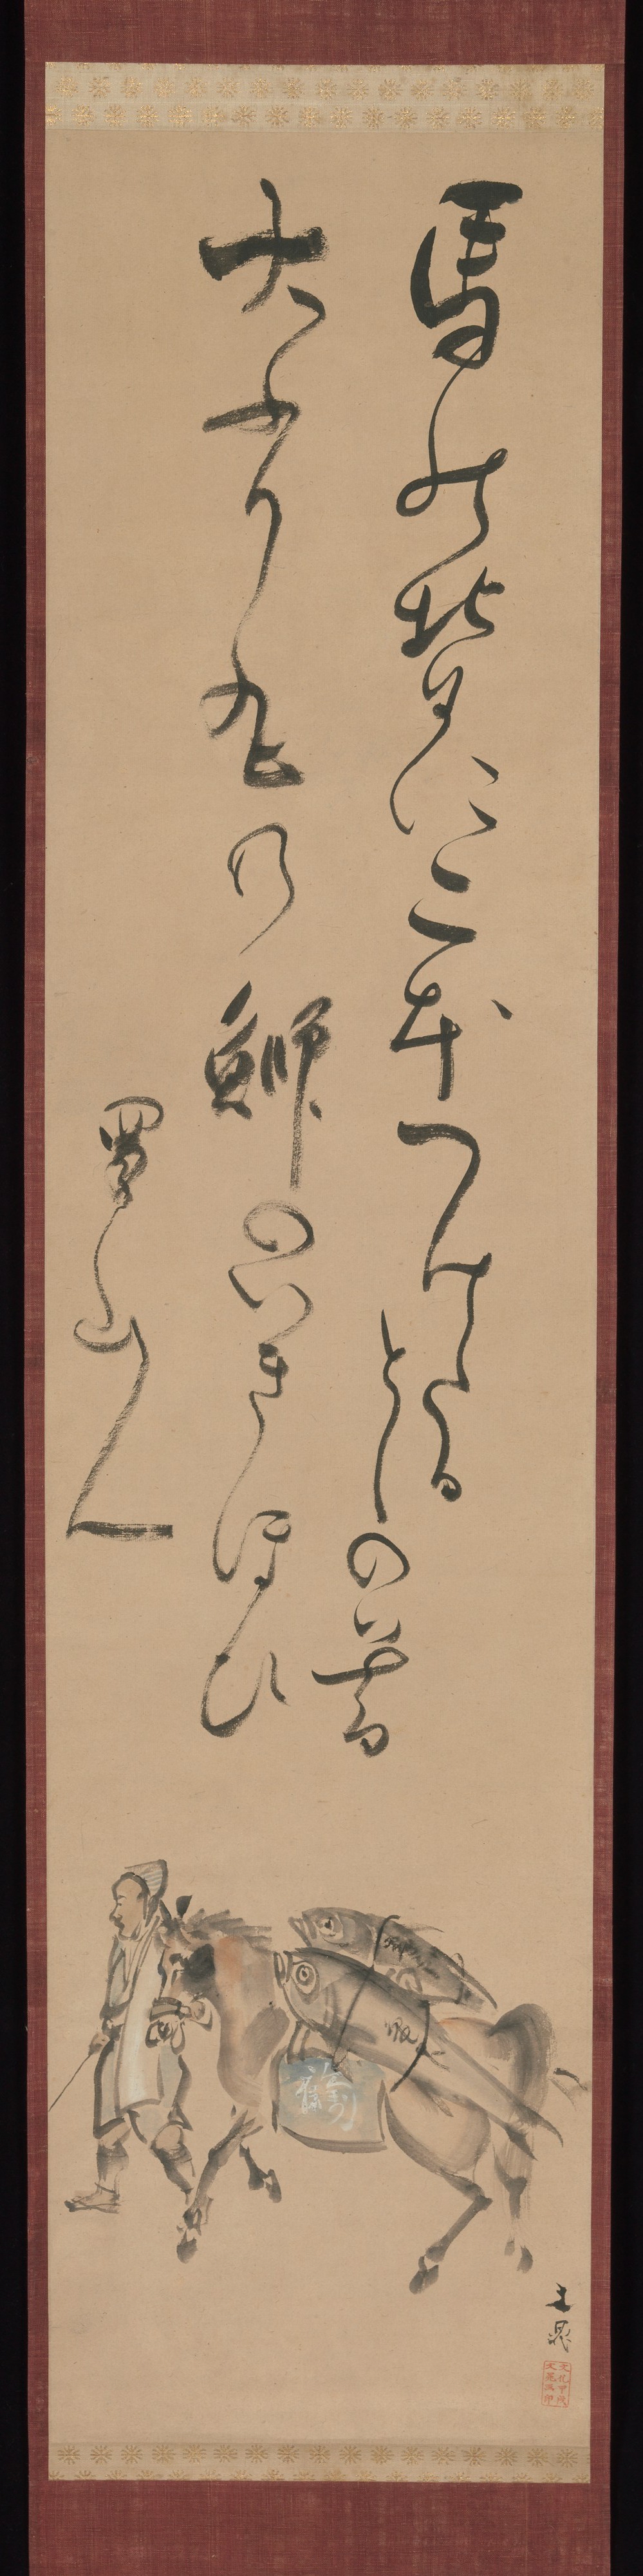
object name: hanging scroll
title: Fish Merchant Carrying Yellowtails on Horseback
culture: japanese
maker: tani bunchō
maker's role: artist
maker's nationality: japanese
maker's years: 1763-1840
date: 1814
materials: ink, paper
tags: men,fish,horses